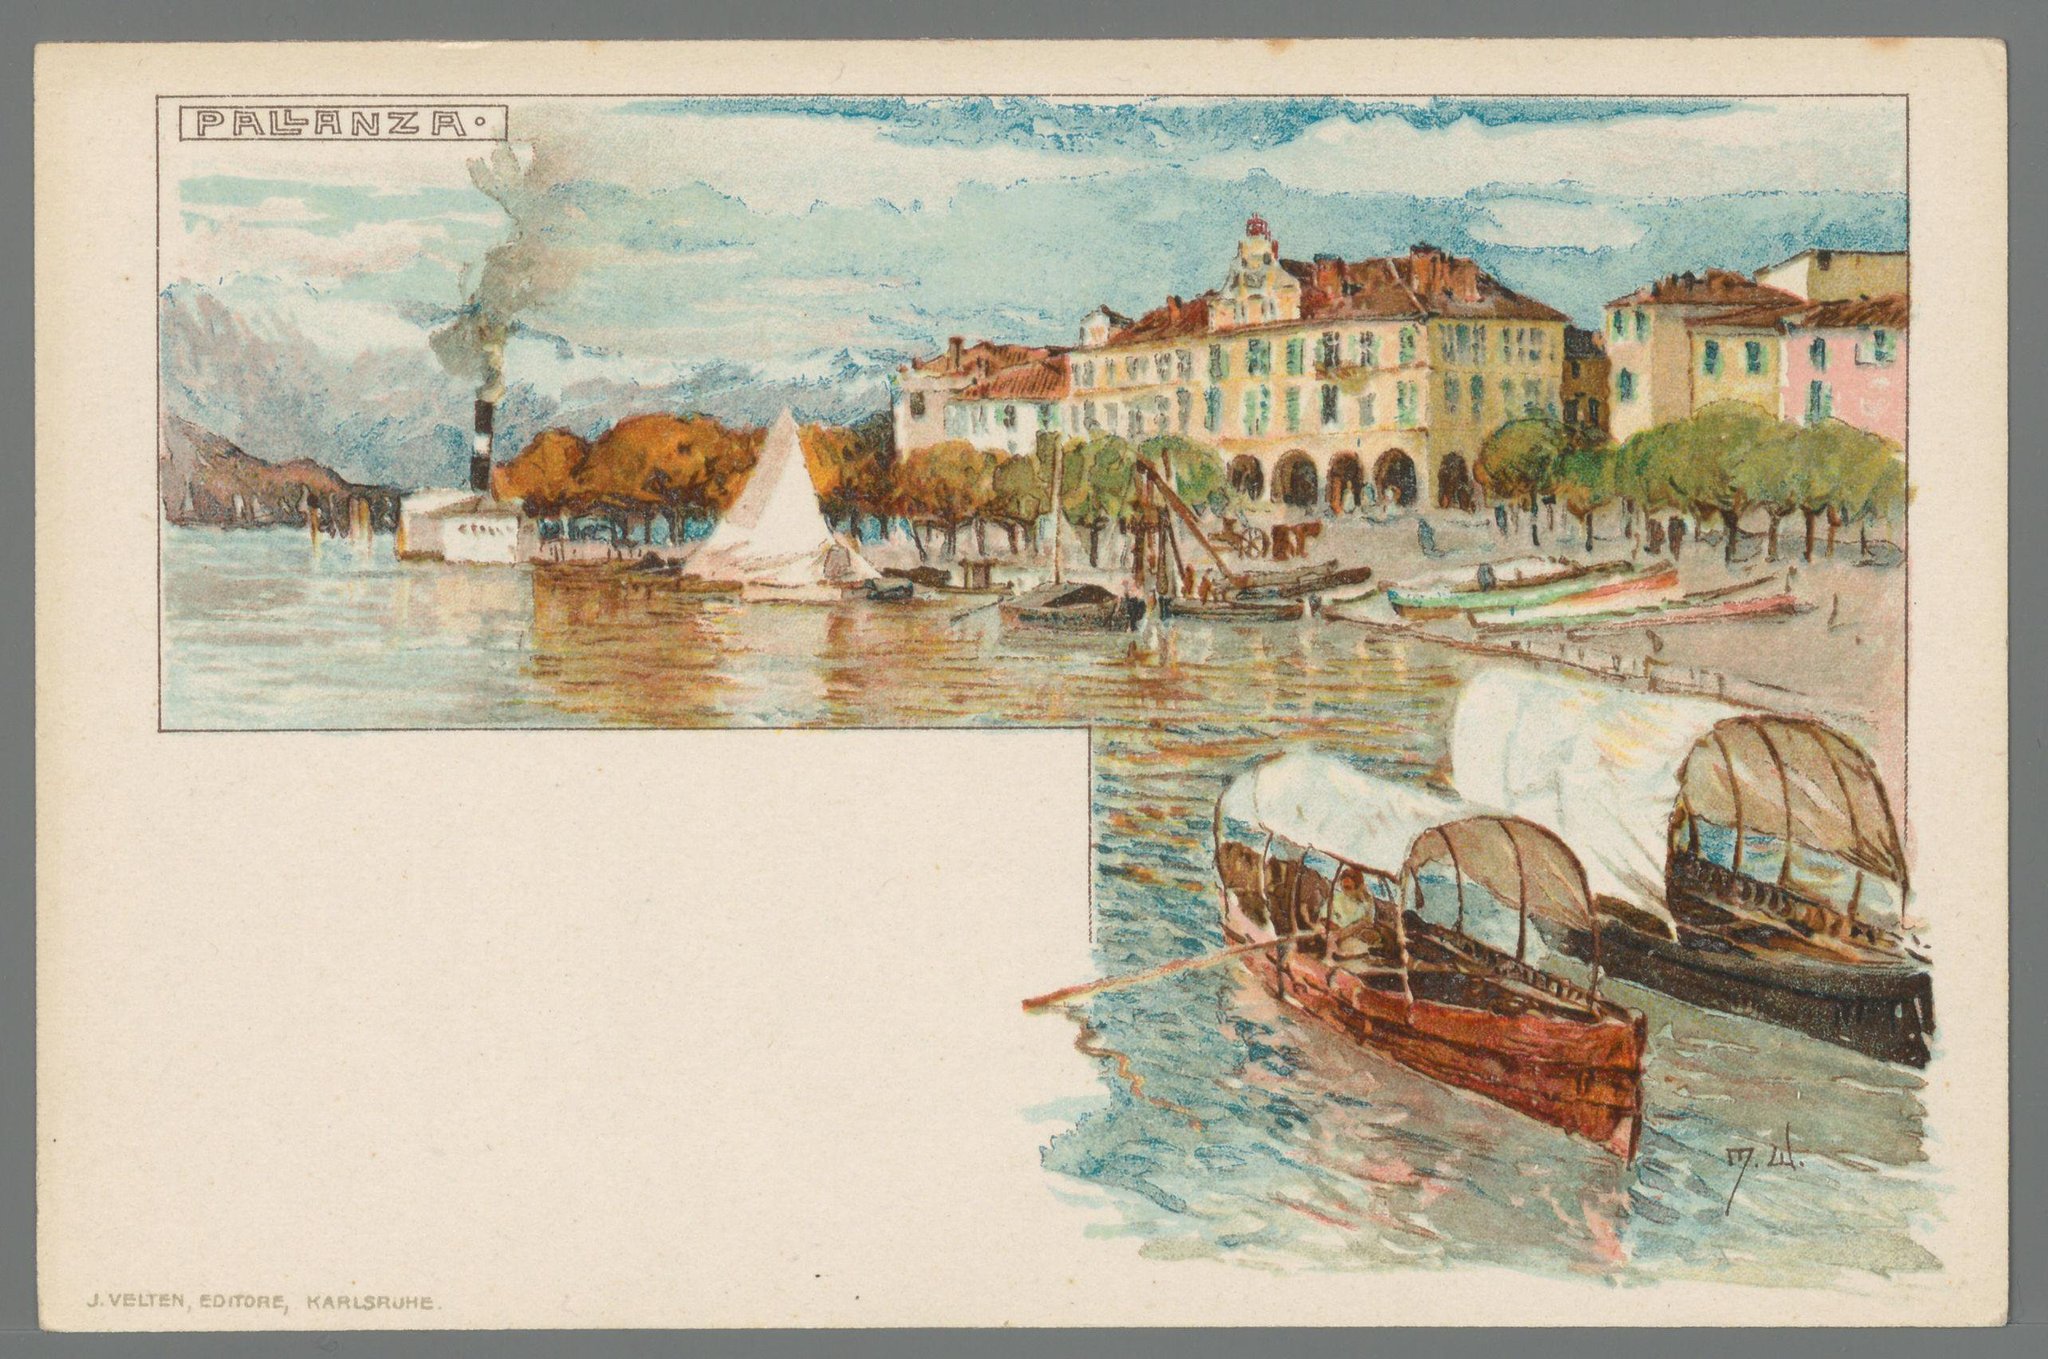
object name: print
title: Pallanza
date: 1905-1909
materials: cardboard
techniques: lithograph, writing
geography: nuremberg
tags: harbour, city-view, and landscape with man-made constructions, lake